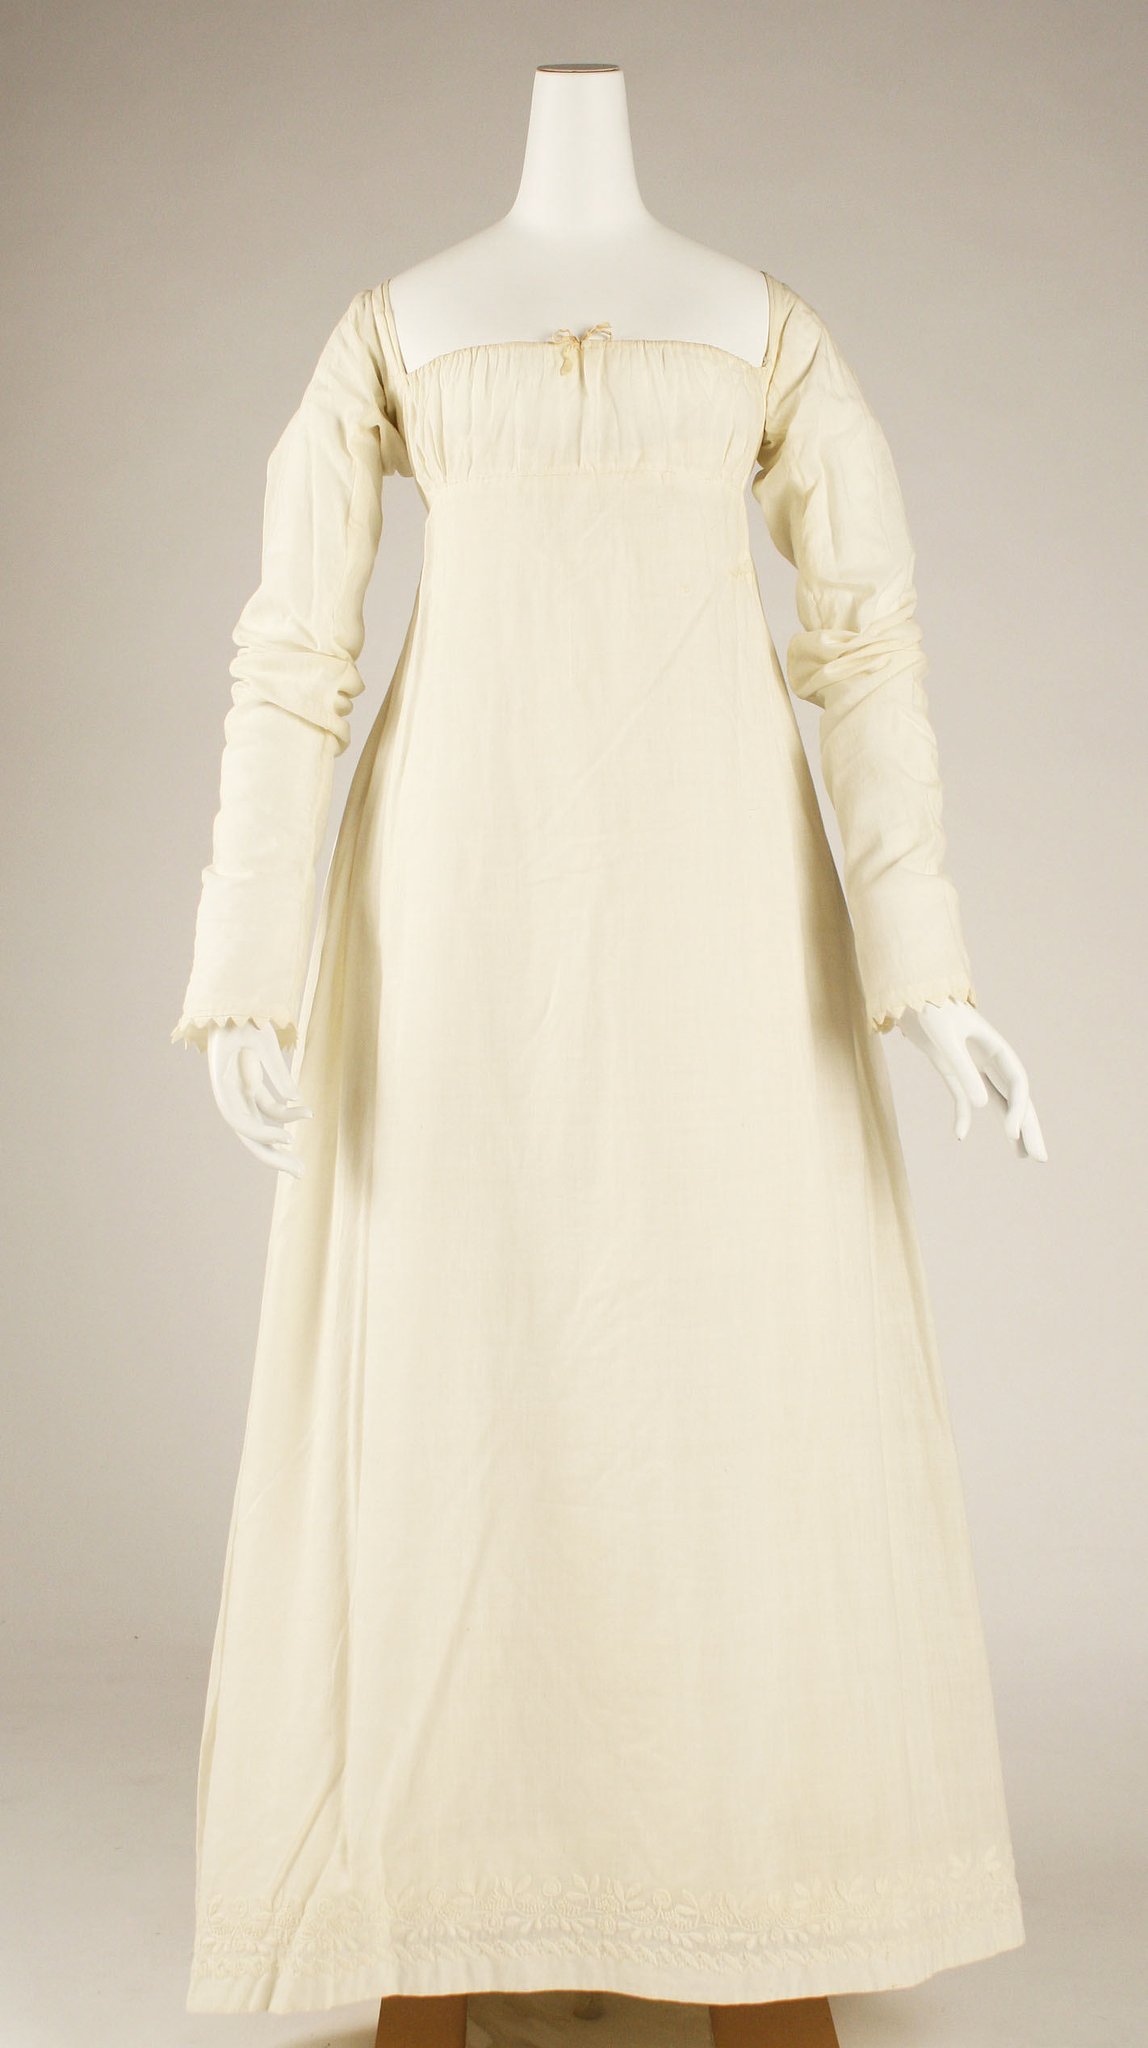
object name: dress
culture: american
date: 1804-1814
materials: cotton